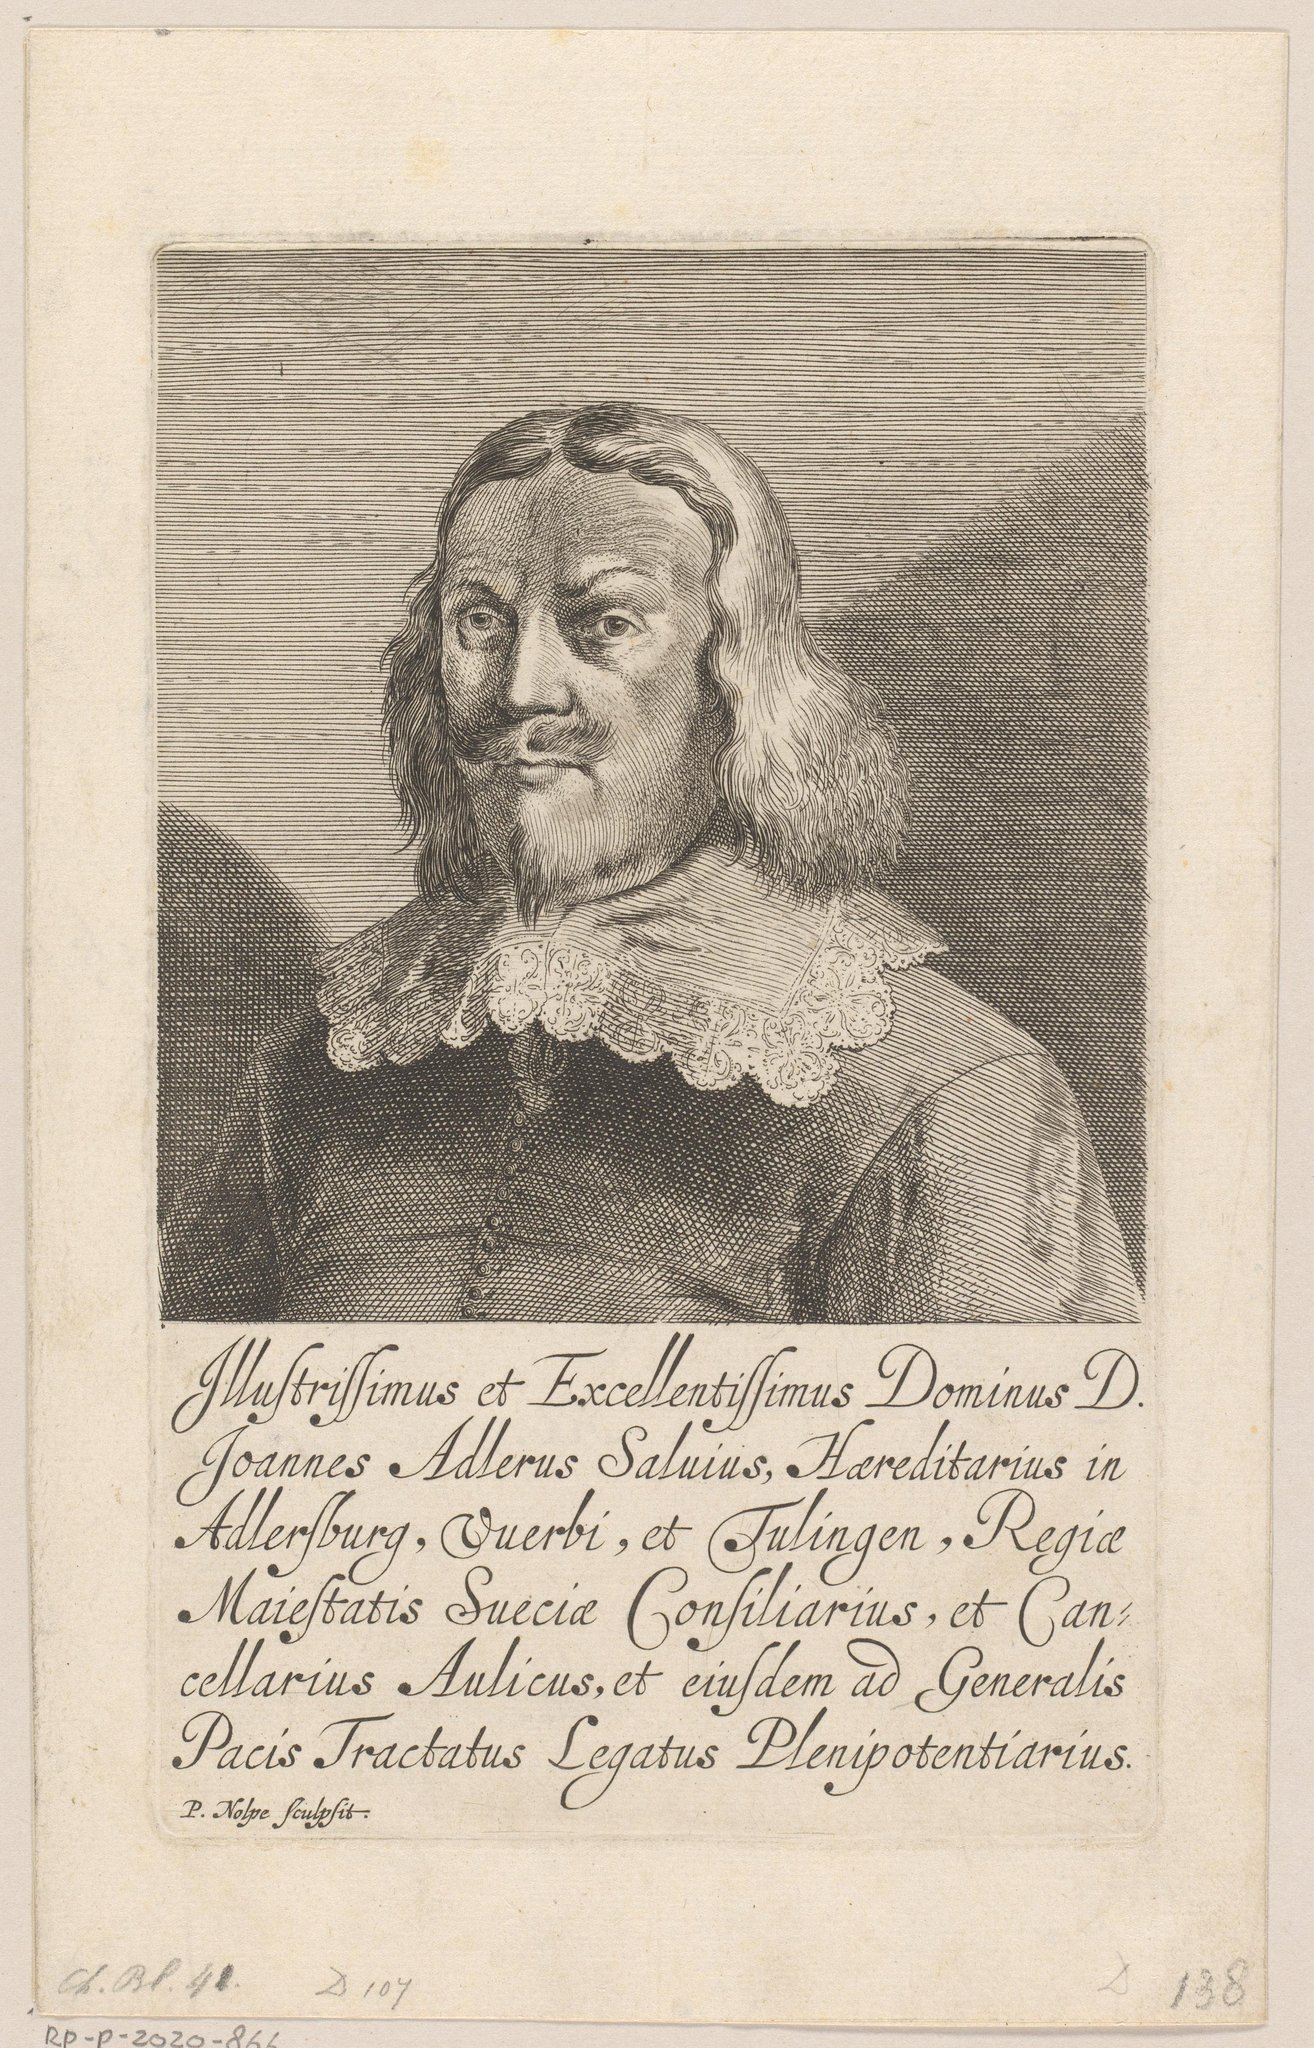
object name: print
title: Icones legatorum Monasterii et Osnabrugae existentium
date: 1644-1646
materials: paper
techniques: engraving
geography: amsterdam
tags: historical persons, diplomacy, diplomat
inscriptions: collector's mark: Lugt 240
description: Prent maakt deel uit van een serie van 43 prenten. Latere staat van prent gebruikt in de serie 'Pacificatores orbis Christiani in Westphaliam missi anno 1641', uitgegeven door Rombout van den Hoeye in Amsterdam.